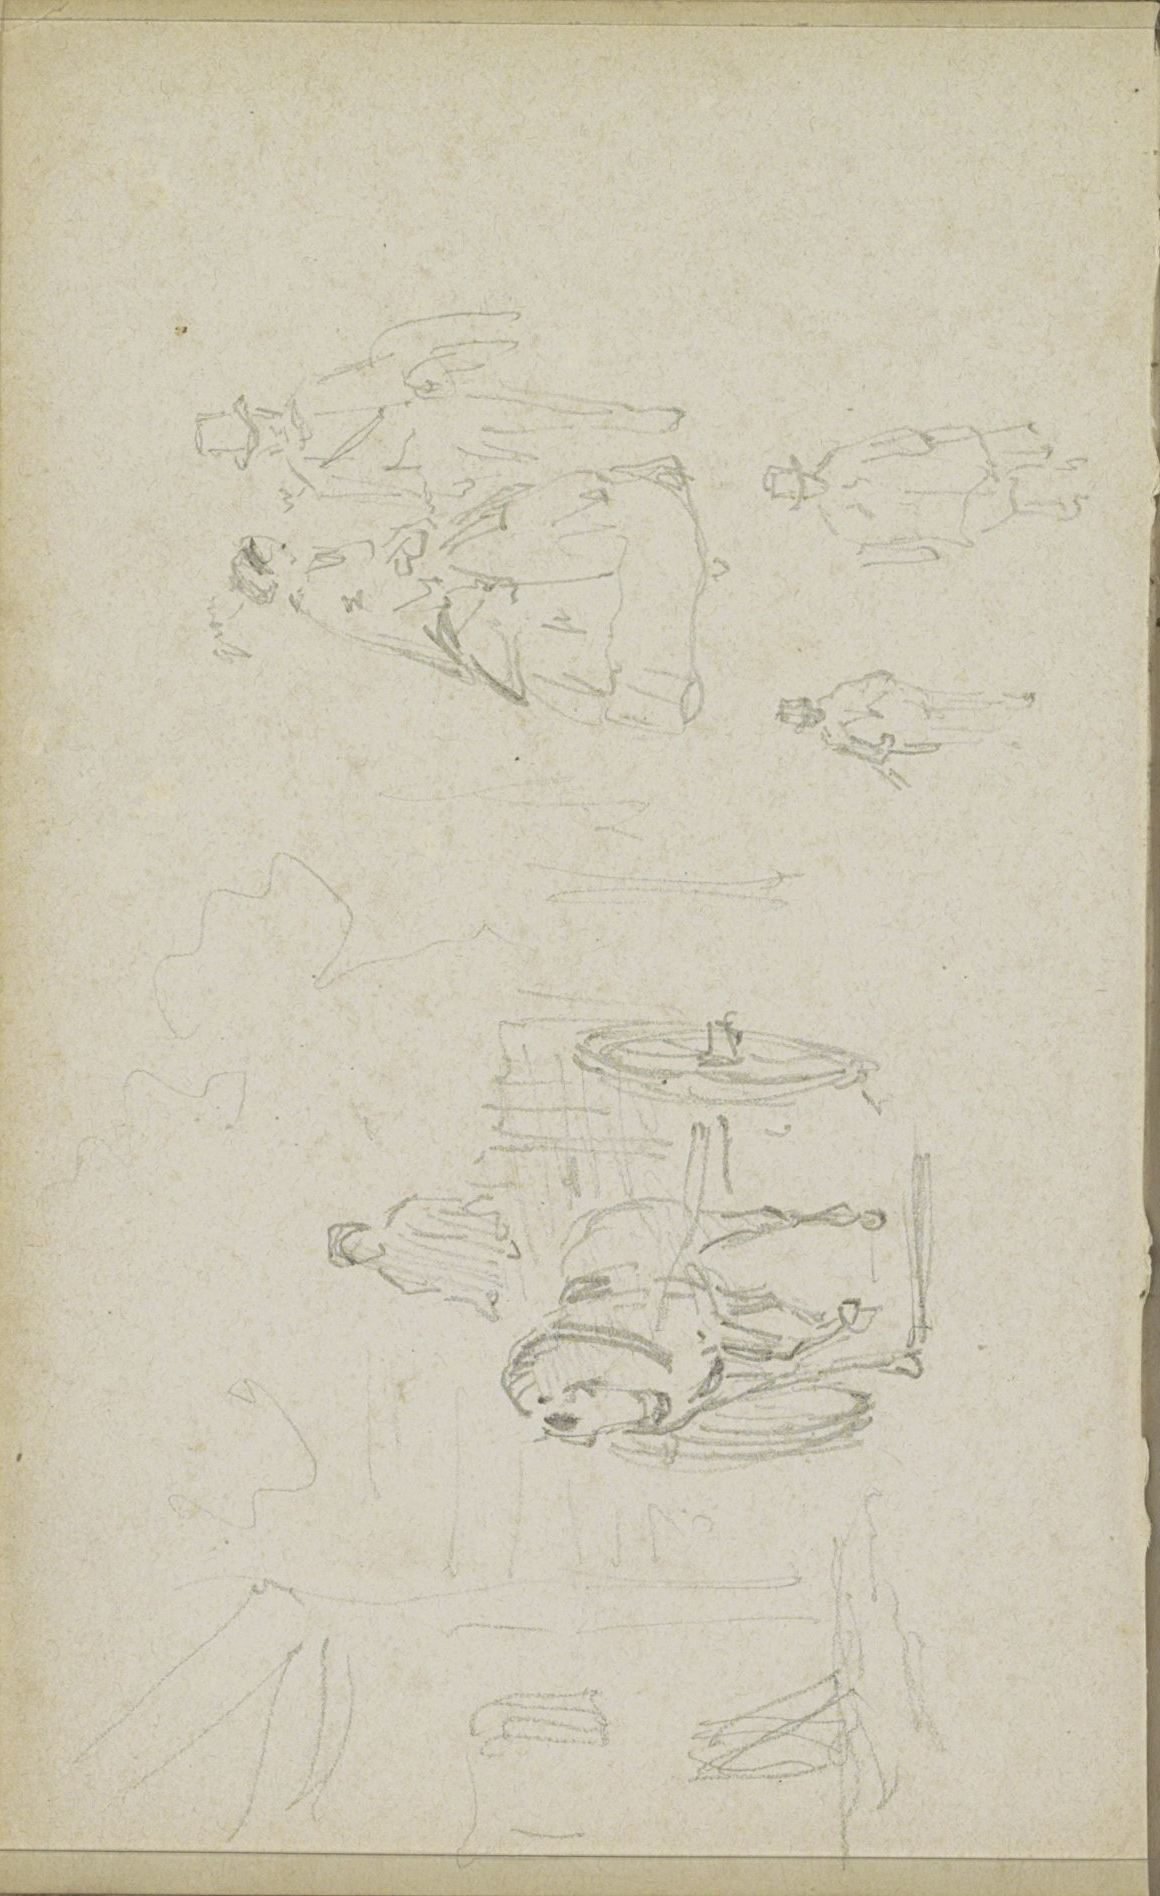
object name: sketchbook leaf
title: Wagen en figuren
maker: adrianus eversen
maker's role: draughtsman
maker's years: 1818-1897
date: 1828-1897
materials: paper, pencil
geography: netherlands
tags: adult woman, adult man, (farm) wagon, freight wagon, cart, farm (building)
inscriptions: kleurnotitie, handgeschreven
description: Links een figuur met paard-en-wagen voor een boerderij. Rechtsboven een vrouw en een man. Daaronder twee studies van een man met een hoge hoed. Blad 3 verso uit een schetsboek met 69 bladen vervaardigd in de omgeving van Delft, Rotterdam, Oudewater en Harlingen.